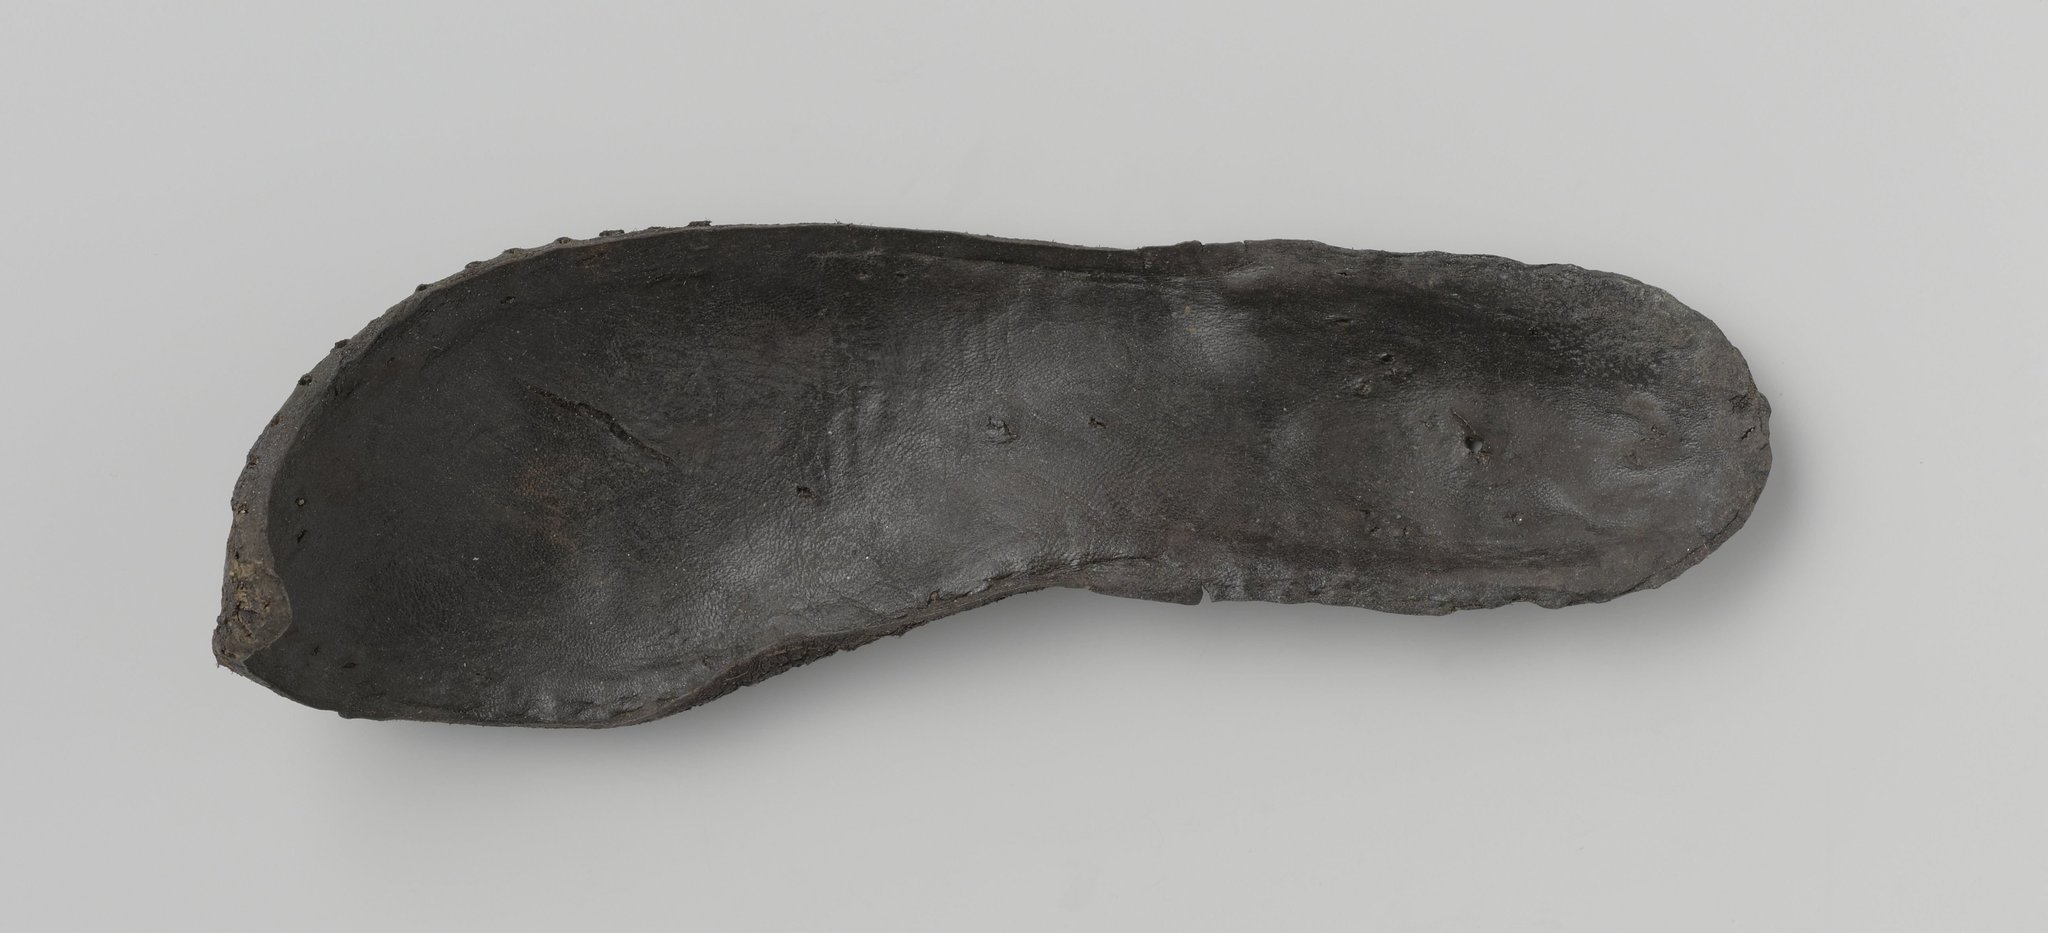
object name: sole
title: Schoenzool uit het wrak van de Oost-Indiëvaarder Hollandia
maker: Anonymous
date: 1700-1743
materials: leather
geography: netherlands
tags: verenigde oostindische compagnie, hollandia (schip), annet